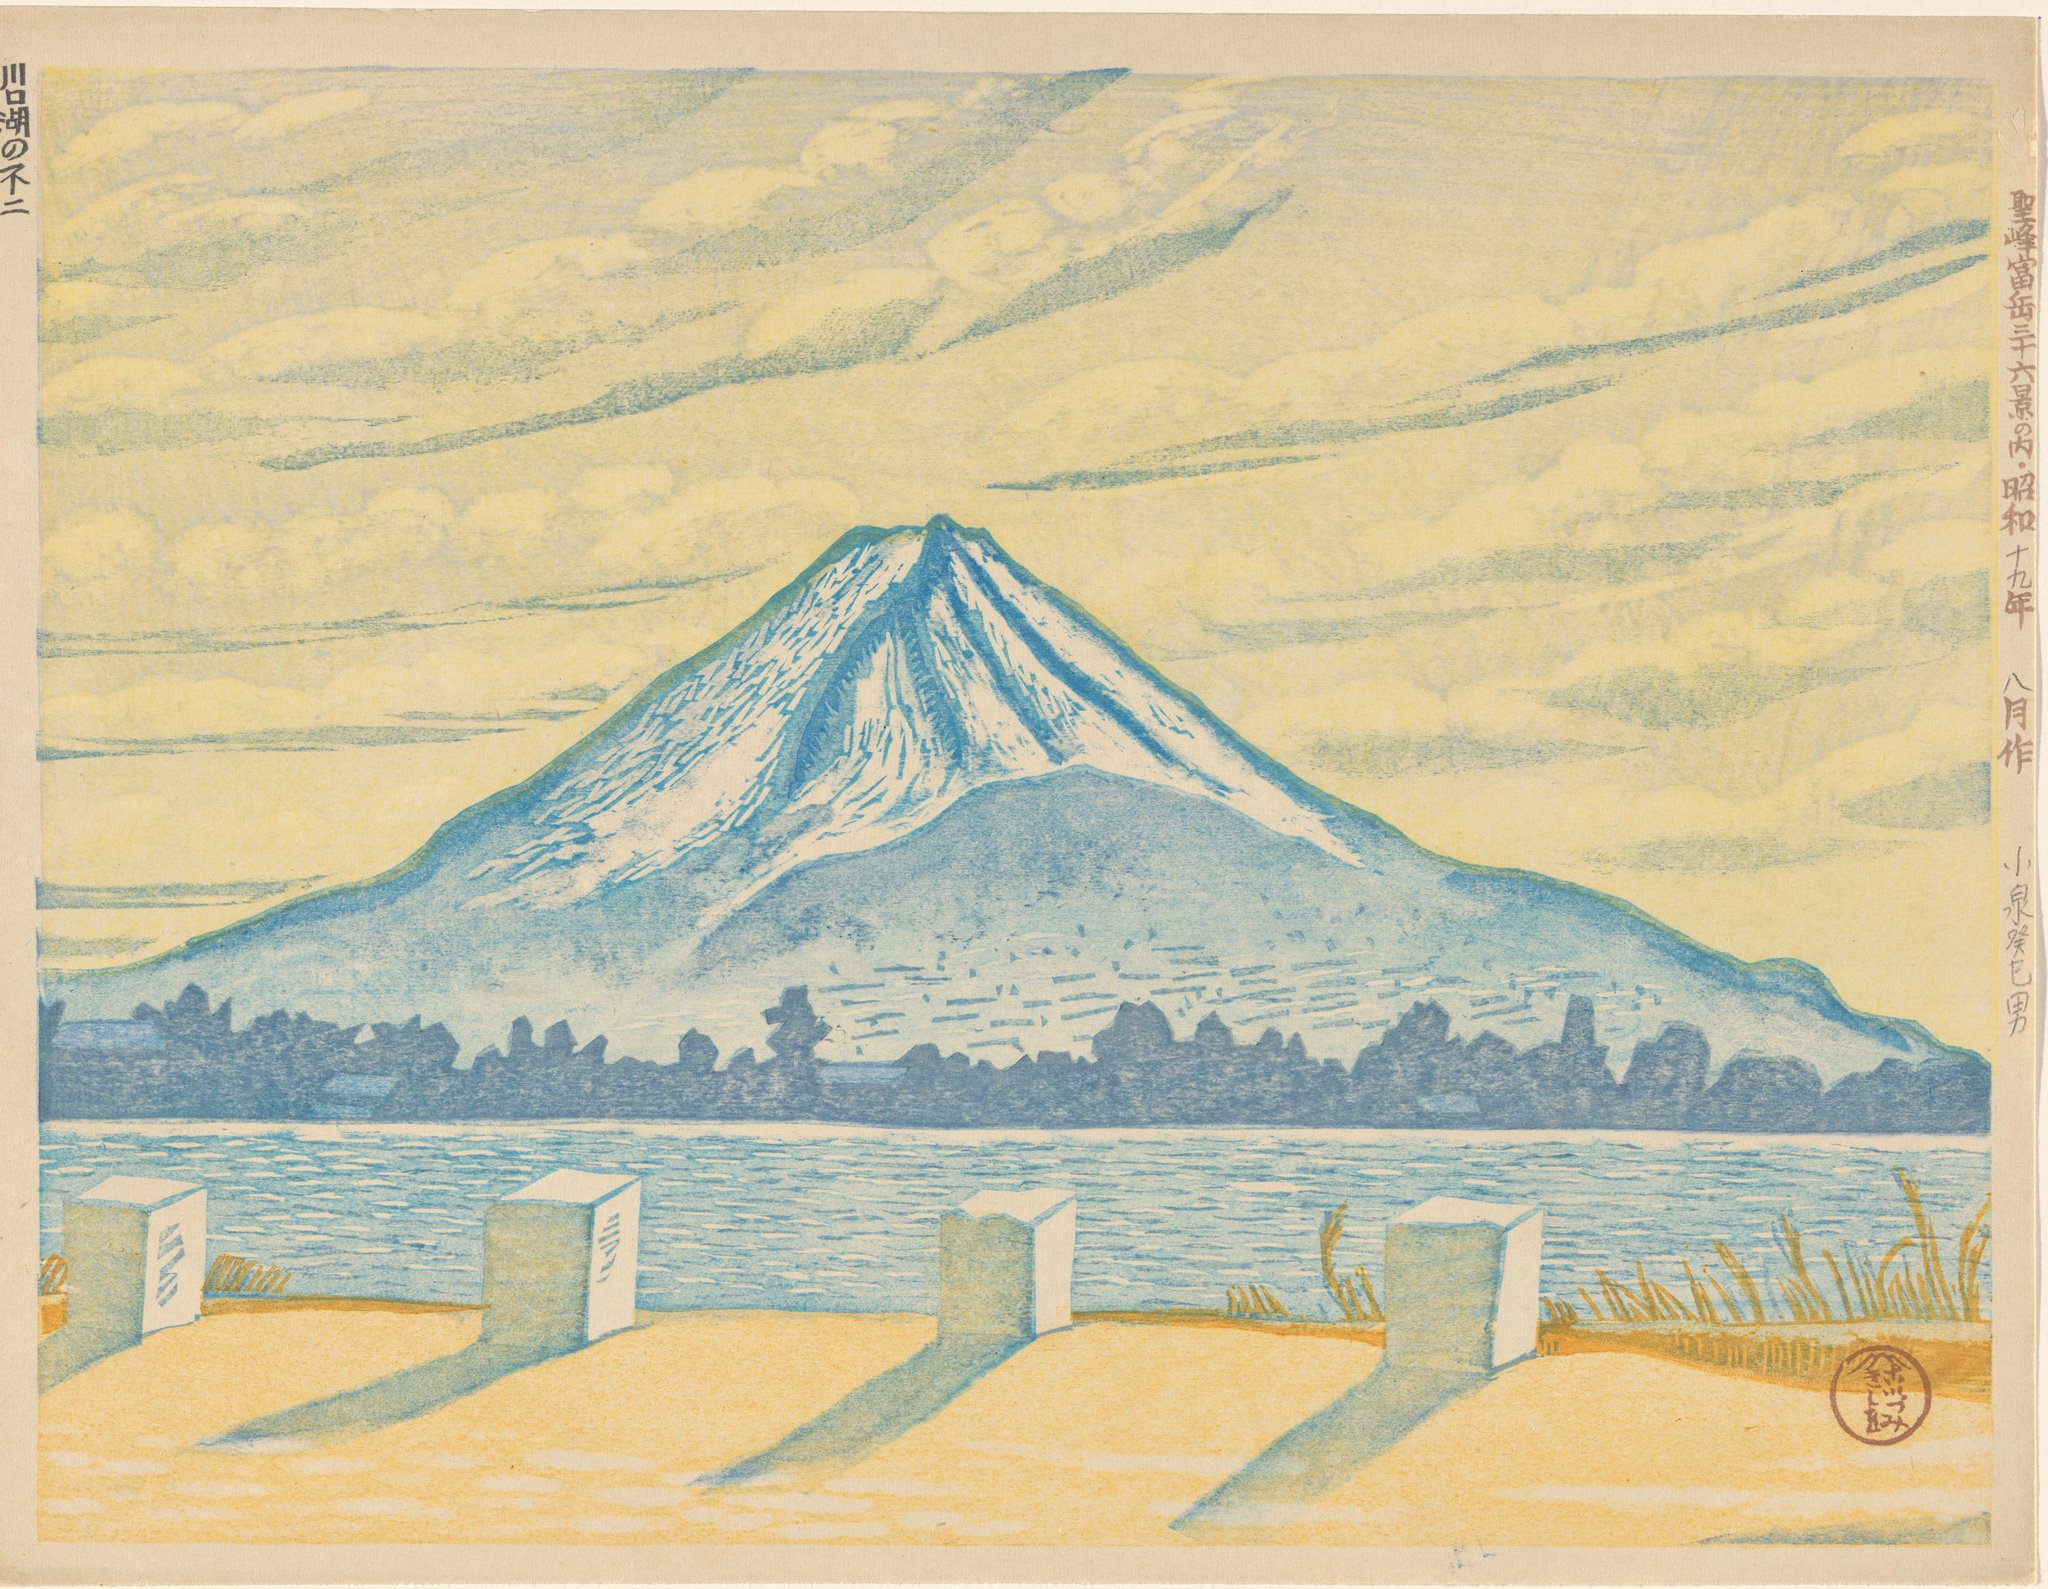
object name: print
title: Thirty-six views of the sacred peak of mount Fuji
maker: koizumi kishio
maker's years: 1893-1945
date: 1908-1944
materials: paper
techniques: woodcut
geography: japan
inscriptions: seal: ‘こいづみきしを’, signature: ‘小泉癸巳男’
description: Een gezicht op de Fuji-berg vanaf de noordelijke oever van het Kawaguchi-meer, laat op een bewolkte dag. Koizumi Kishio begon in 1940 aan zijn project 'Zesendertig gezichten op de heilige berg Fuji', een knipoog naar de welbekende prenten uit de jaren 1830 van Katsushika Hokusai (1760–1849). Vanwege de geallieerde bombardementen vluchtte hij naar zijn schoonouders in Saitama, ten noorden van Tokyo. Hij voltooide 23 ontwerpen voor hij bezweek aan ziekte in 1945.